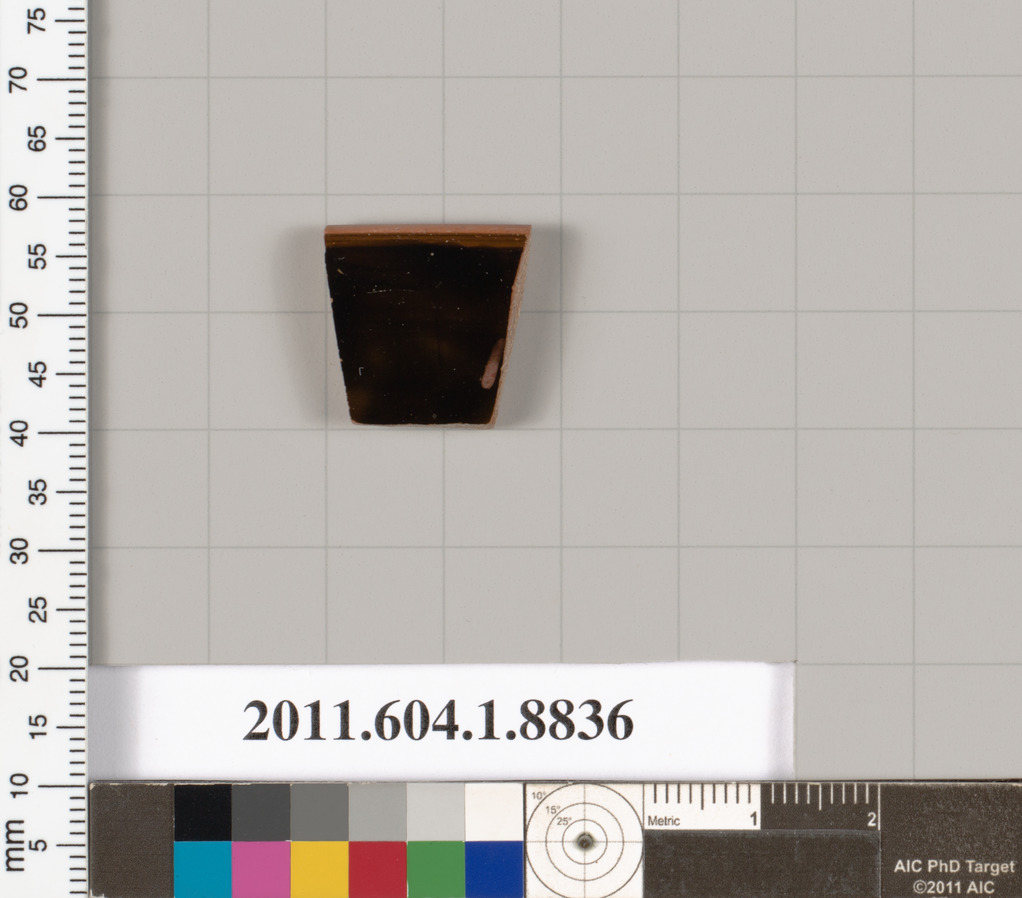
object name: kylix fragment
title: Terracotta rim fragment of a kylix (drinking cup)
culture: greek, attic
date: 500-480 BCE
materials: terracotta